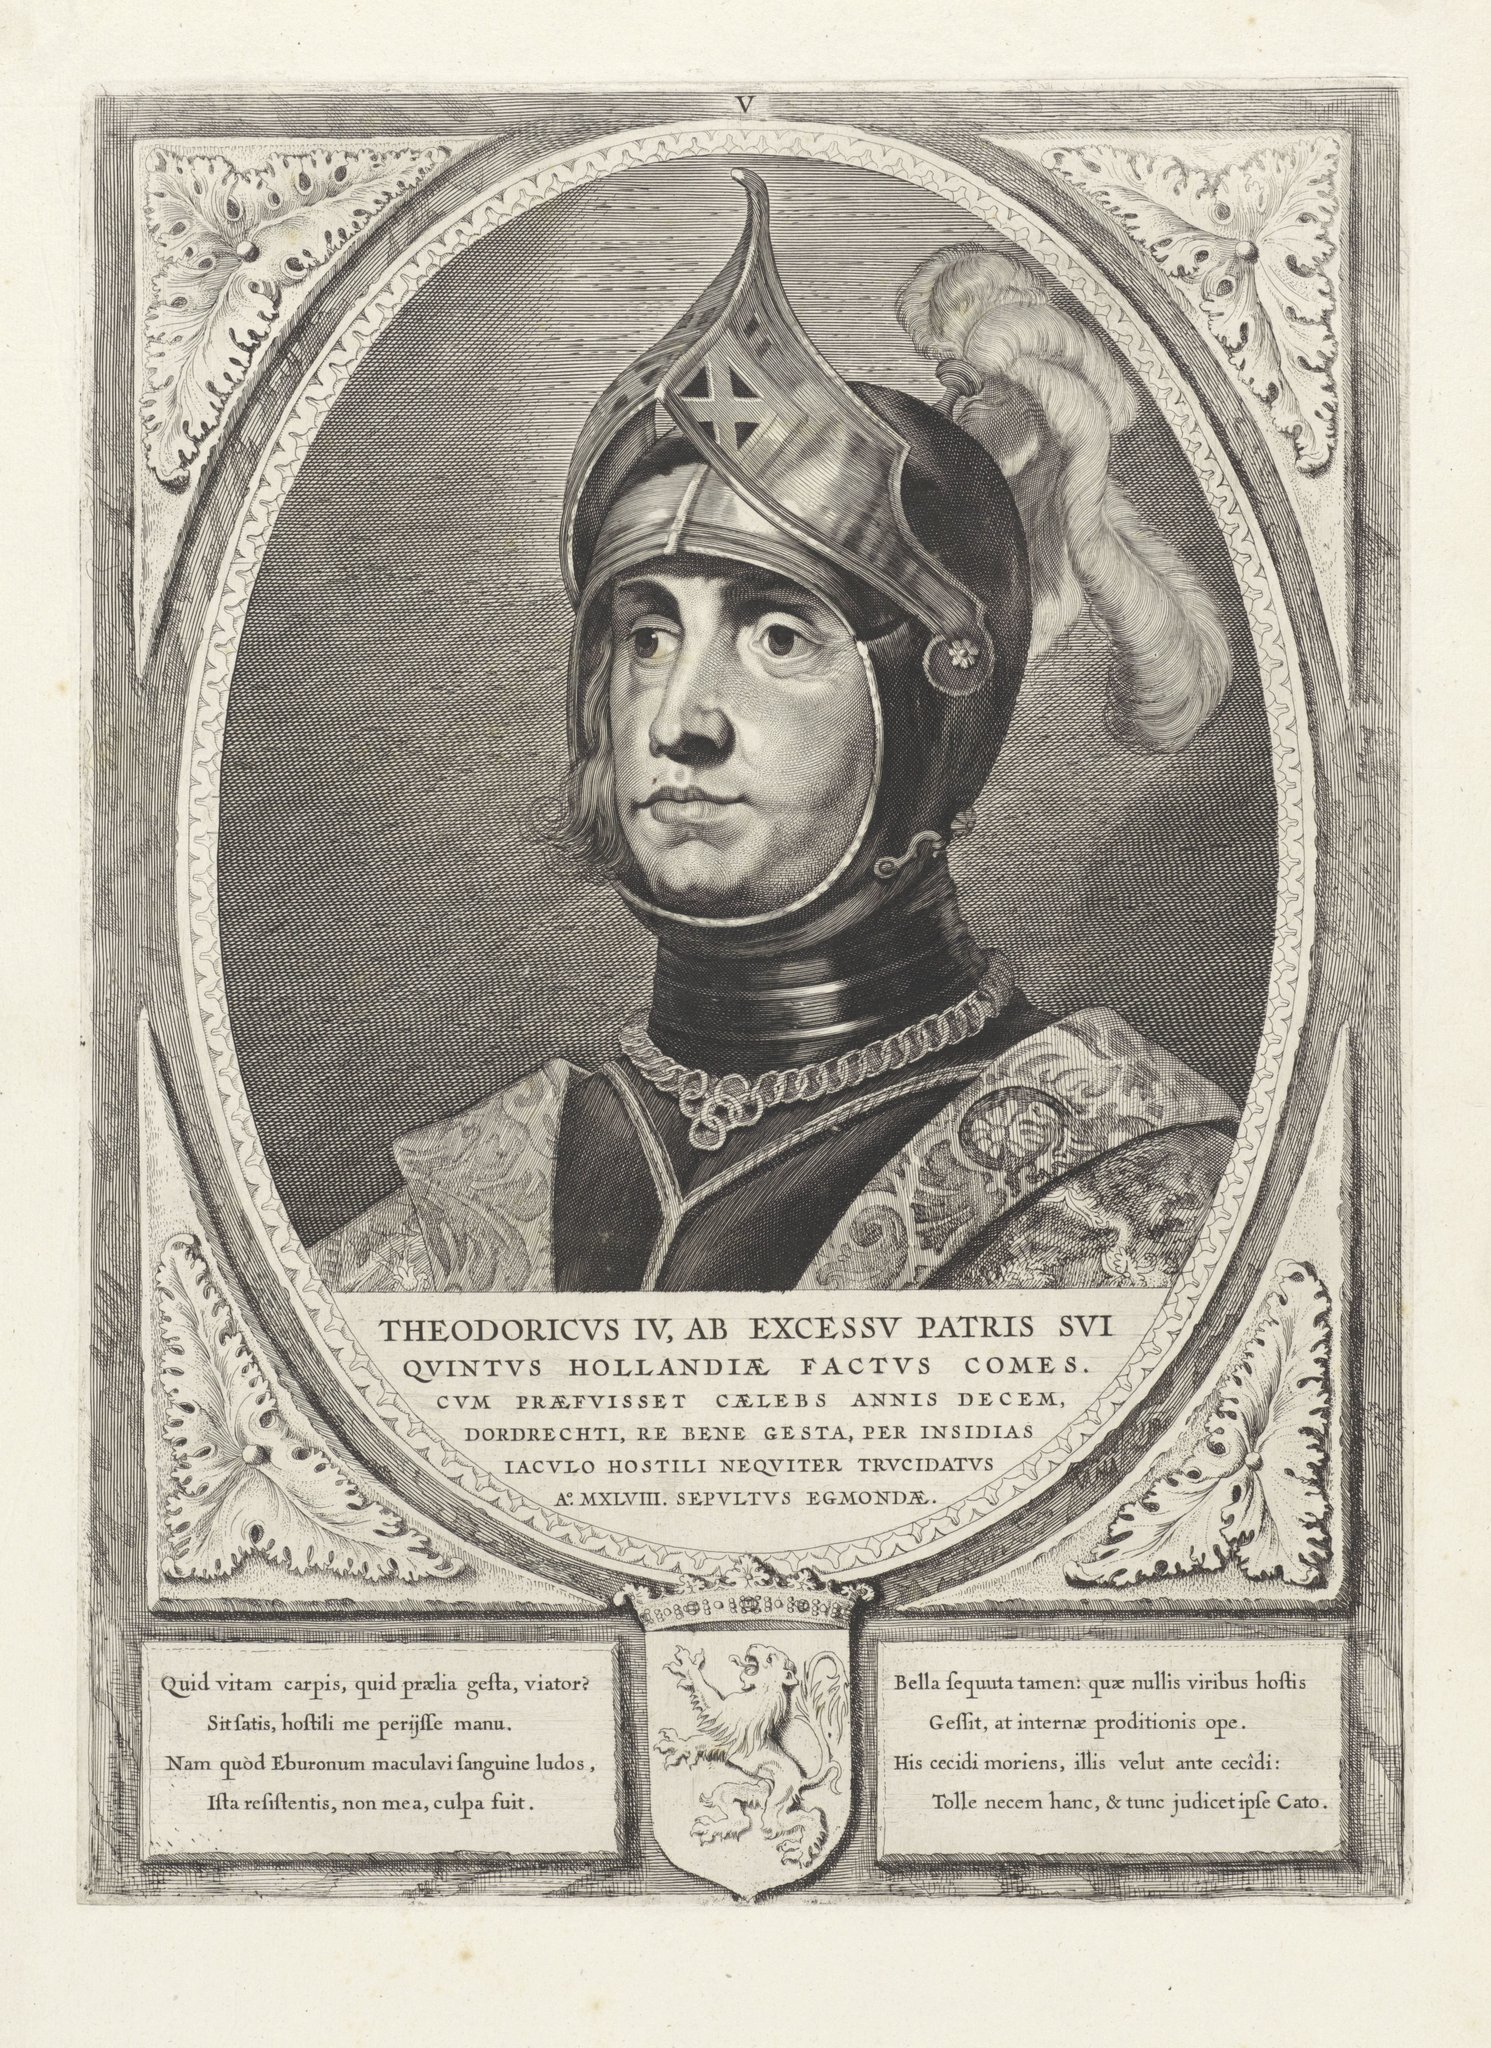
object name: print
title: Portret van Dirk IV, graaf van Holland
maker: cornelis visscher (ii)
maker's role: draughtsman, painter, print maker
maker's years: 1628-1658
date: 1650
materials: paper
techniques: engraving, etching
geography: haarlem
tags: helmet, armour, nobility and patriciate; chivalry, knighthood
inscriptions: collector's mark: Lugt 12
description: Proefdruk van de vijfde prent uit de serie 'Graven en gravinnen van Holland, Zeeland en West-Friesland', bestaande uit 38 prenten.